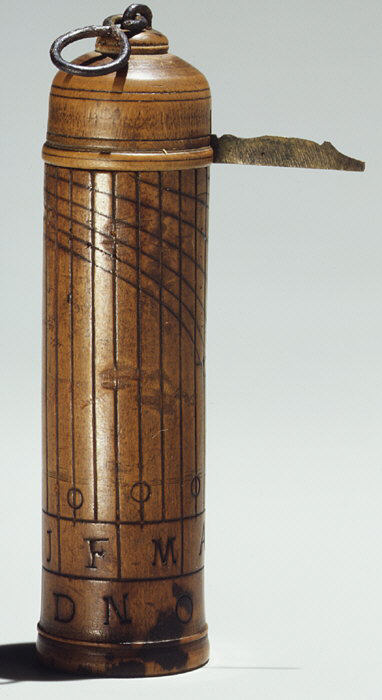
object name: pillar dial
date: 1701-1800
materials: wood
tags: sundials